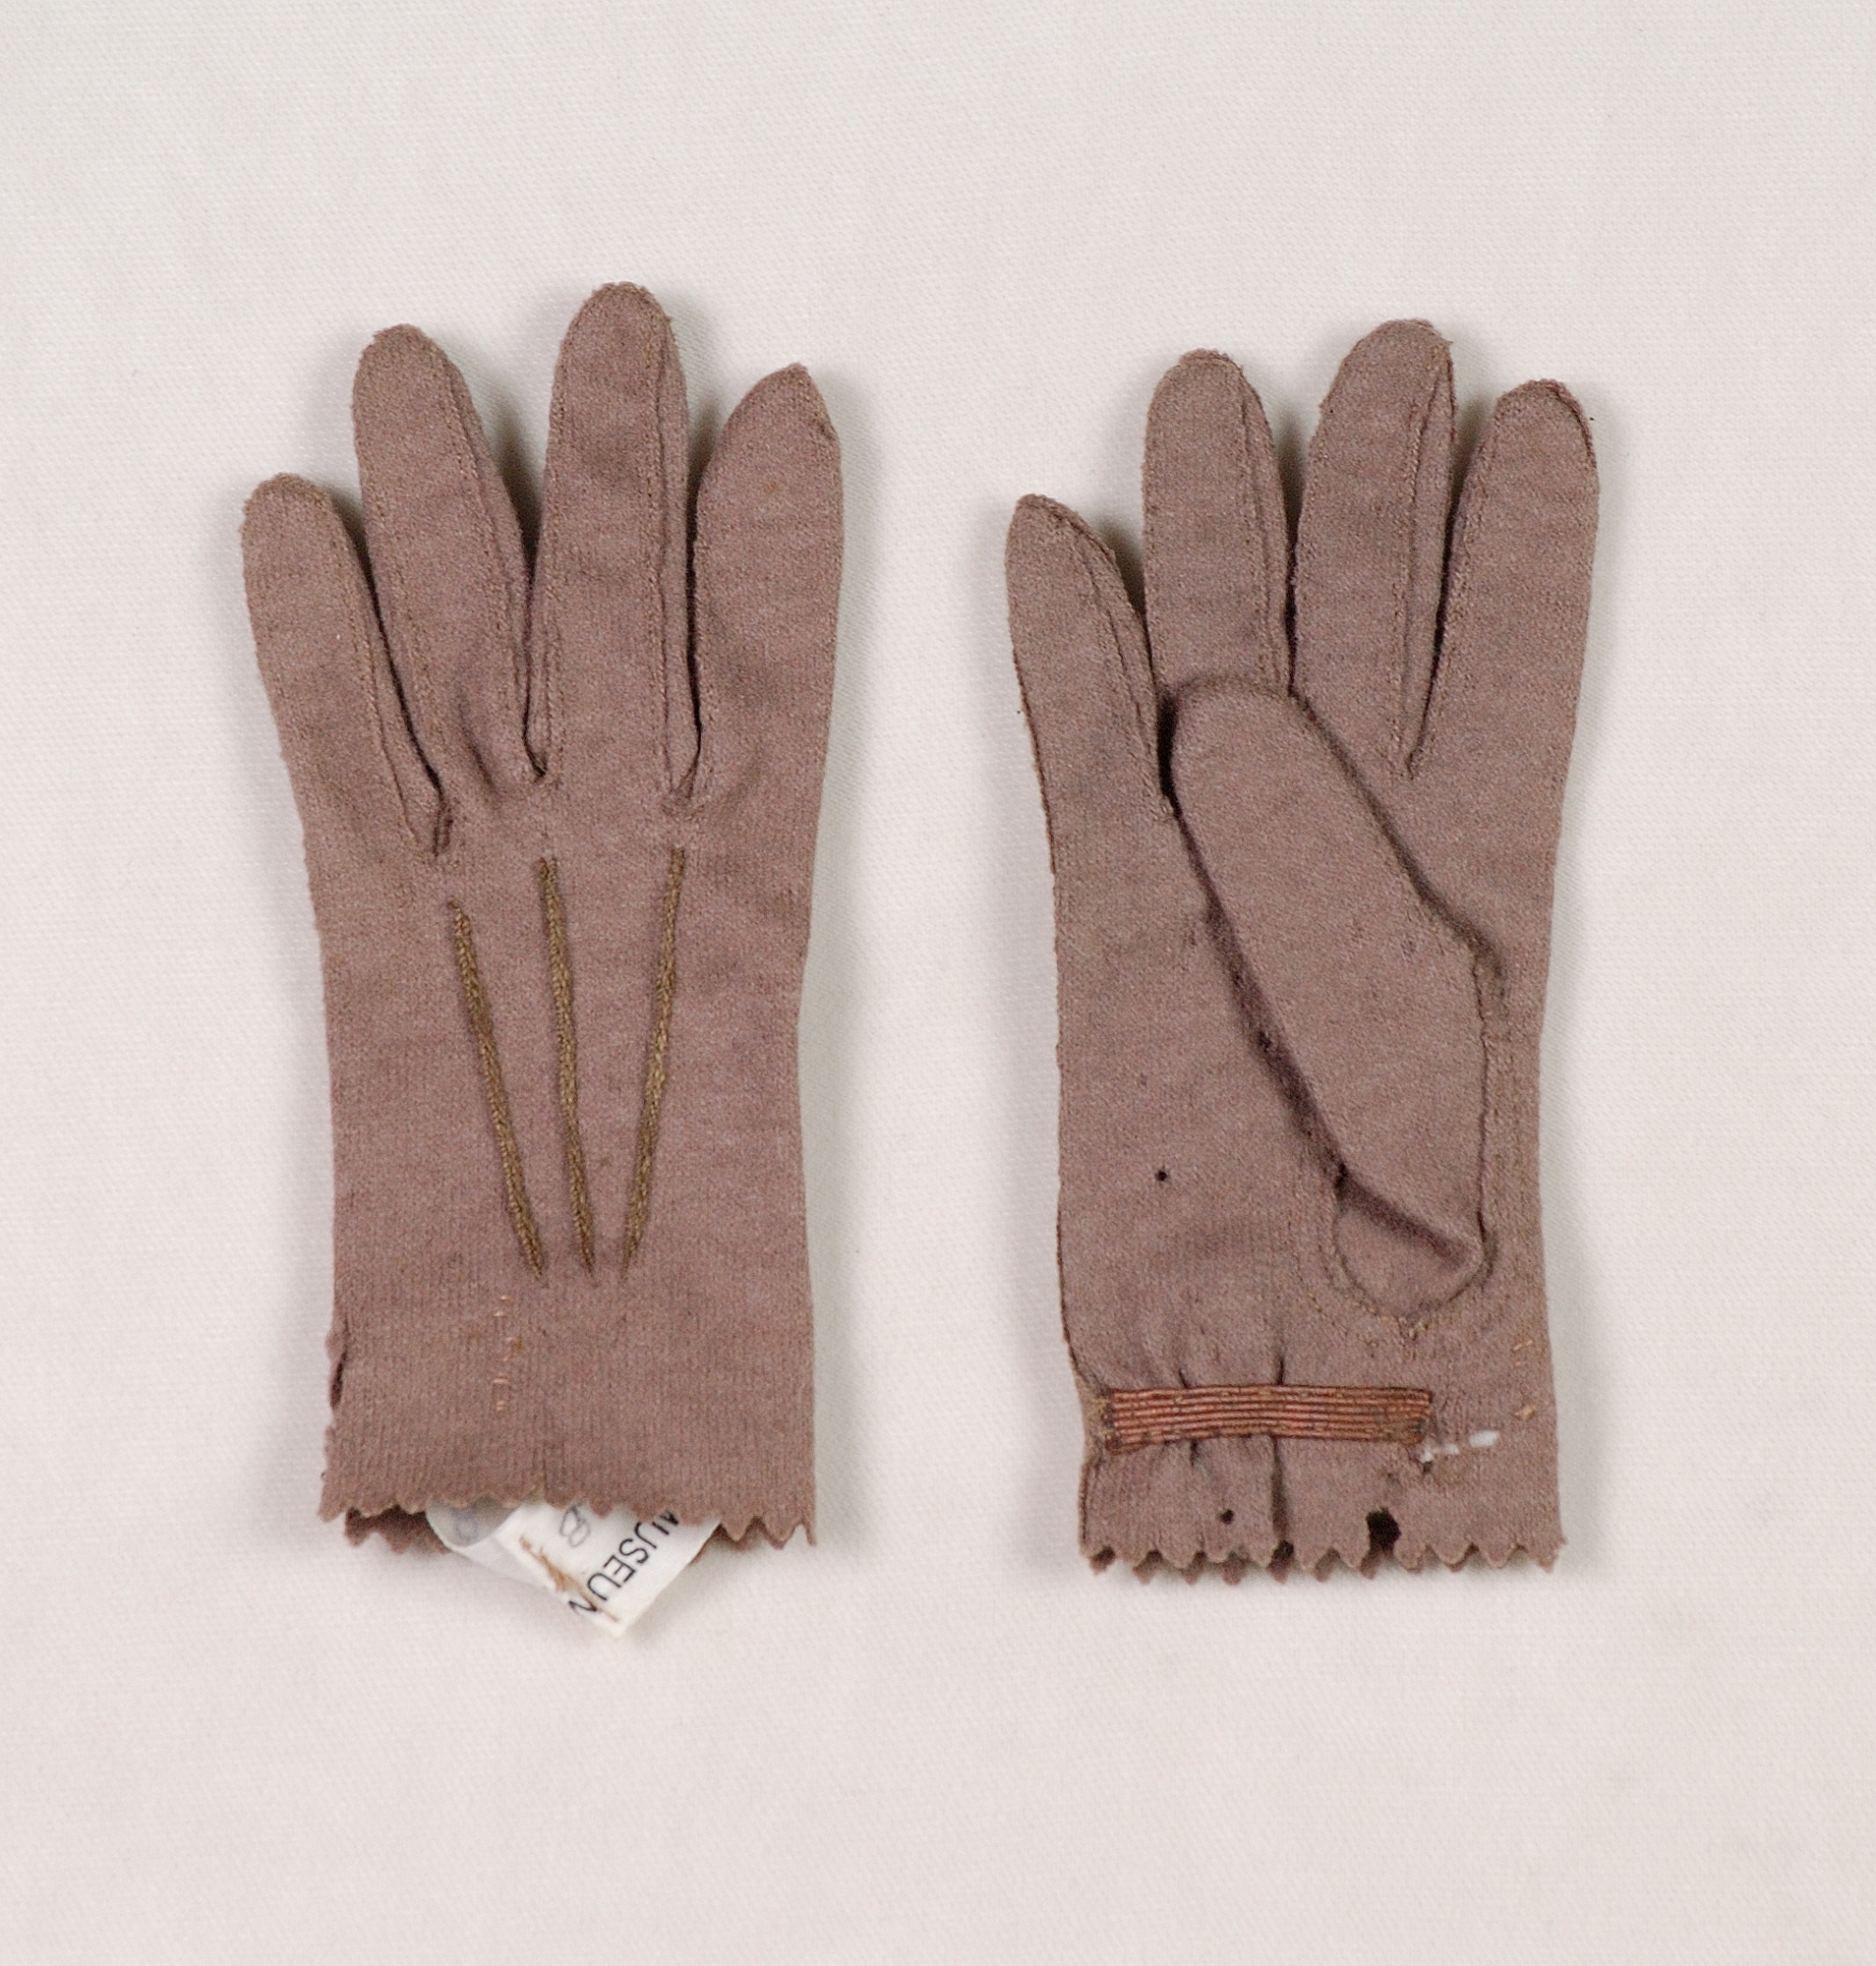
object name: glove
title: Gloves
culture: american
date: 1851-1875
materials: wool